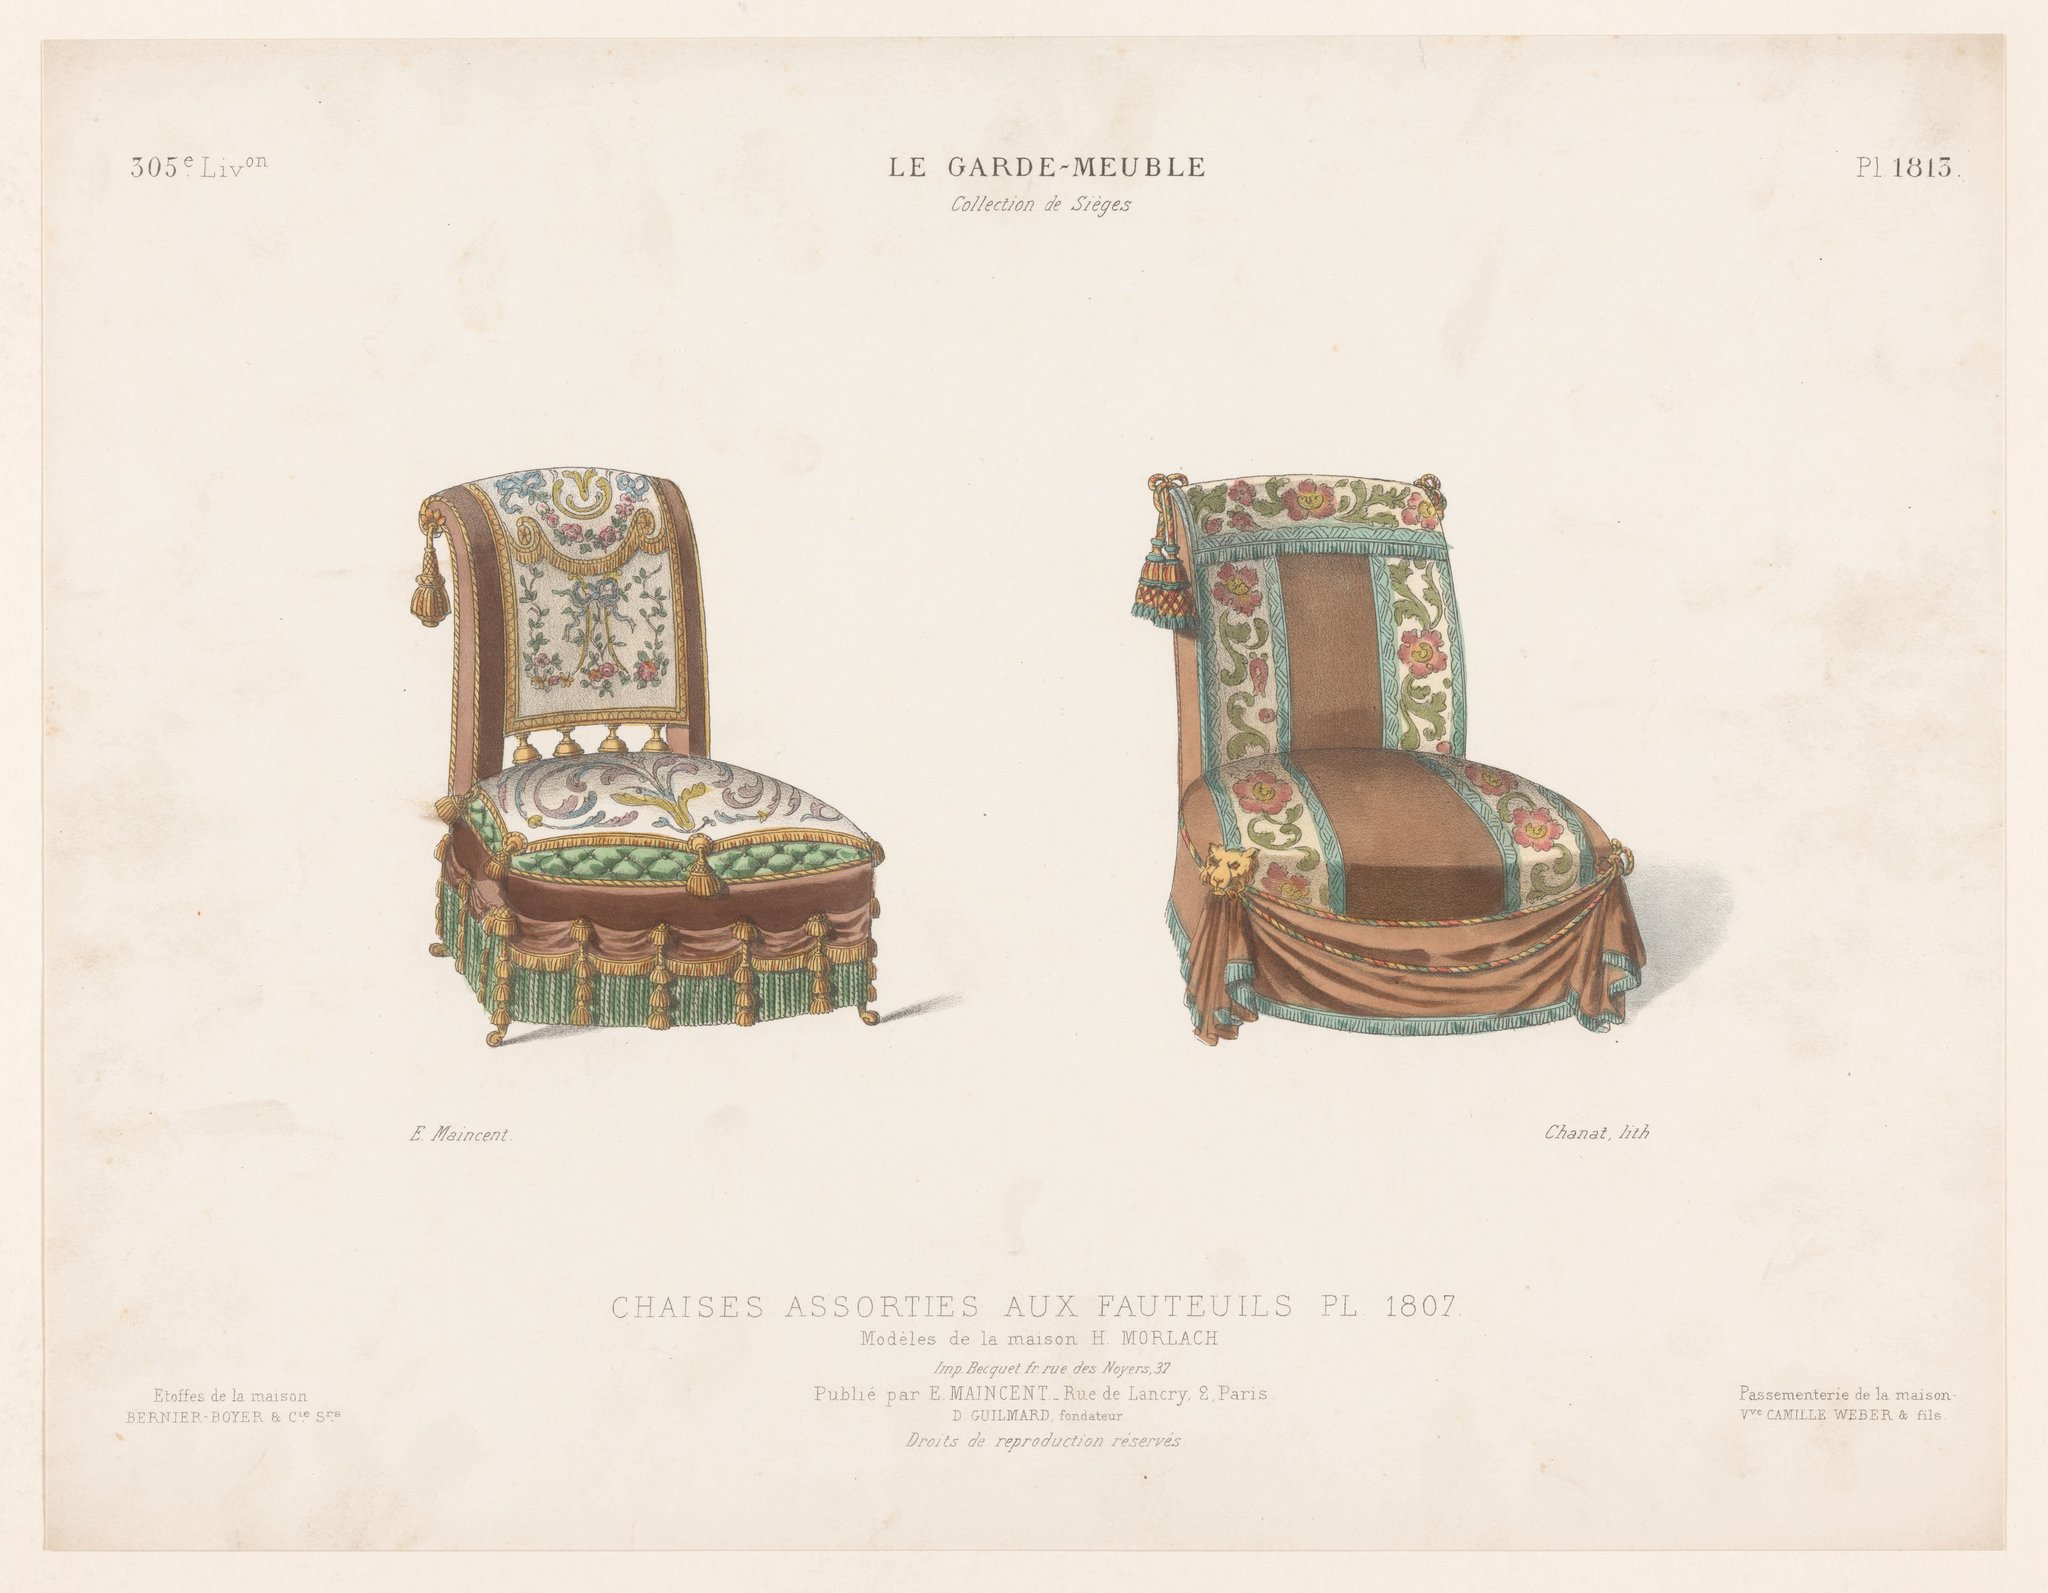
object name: print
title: Chaises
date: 1885-1895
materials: paper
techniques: hand coloring, lithograph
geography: paris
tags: seating furniture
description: Ieder Livraison in de serie Le Garde-Meuble bevat negen platen: drie 'sièges' (zitmeubels), drie 'meubles' (diverse meubels zoals tafels en kasten) en drie 'tentures' (gordijnen en draperieën).